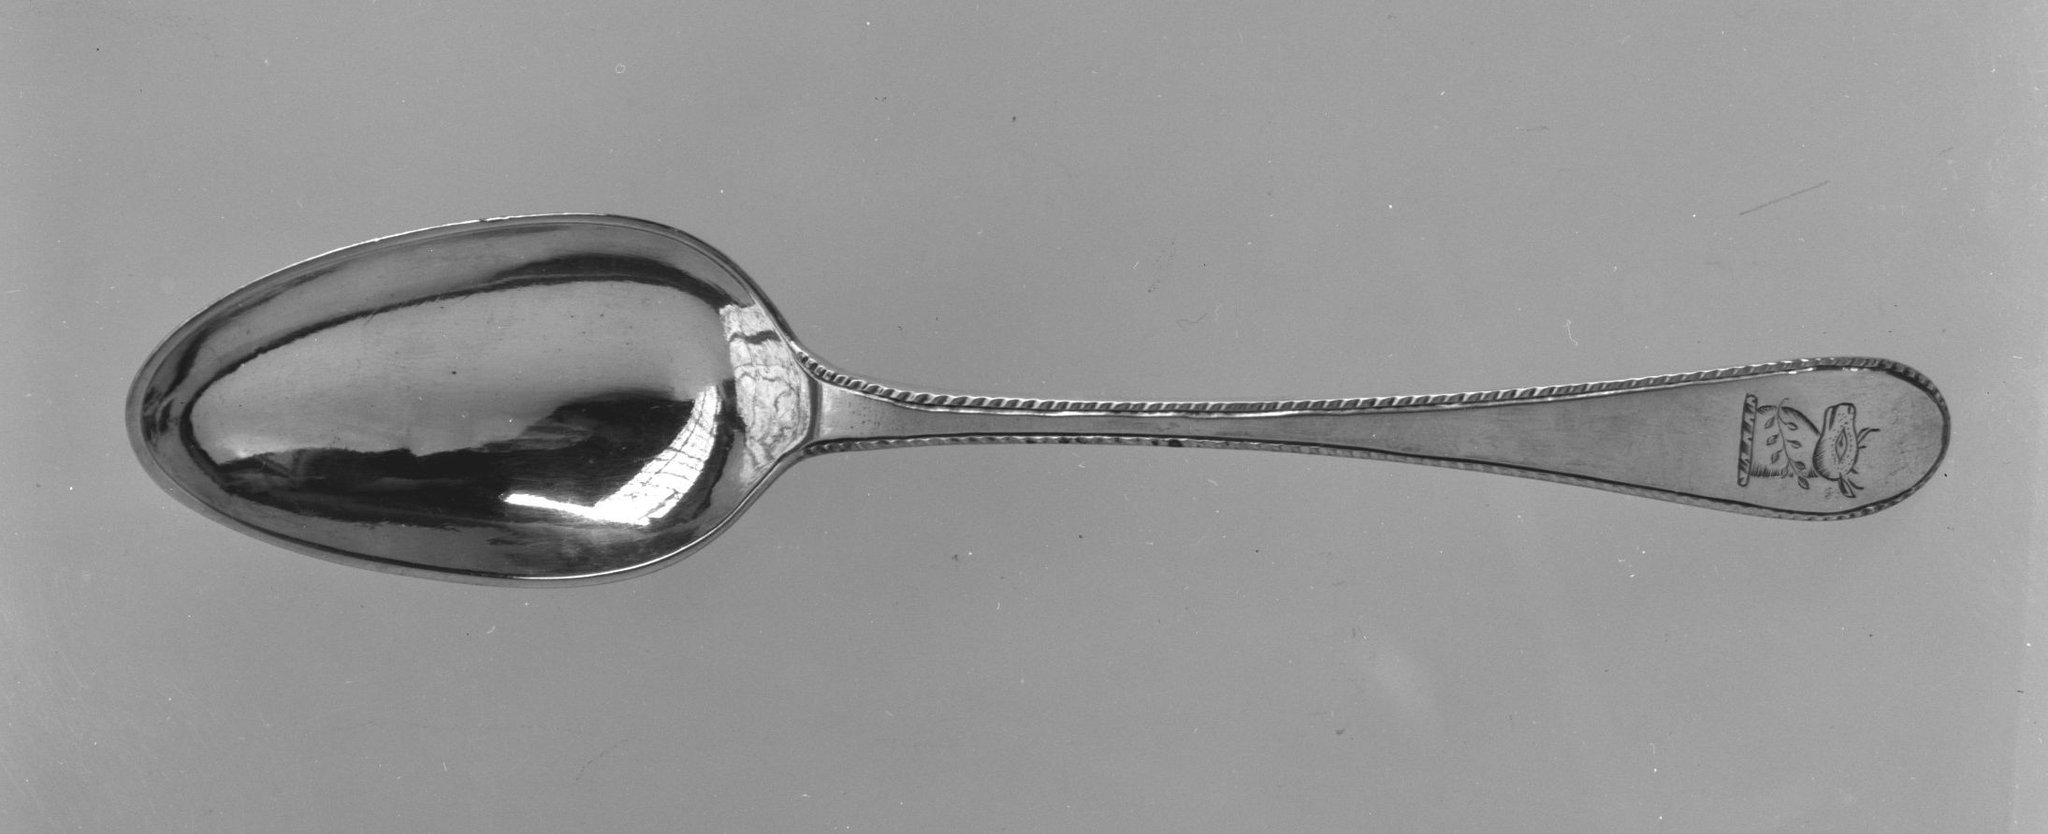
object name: spoon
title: Dessert Spoon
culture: american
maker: john burt lyng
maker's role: maker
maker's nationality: american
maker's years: 1758-1785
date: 1700-1800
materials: silver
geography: united states